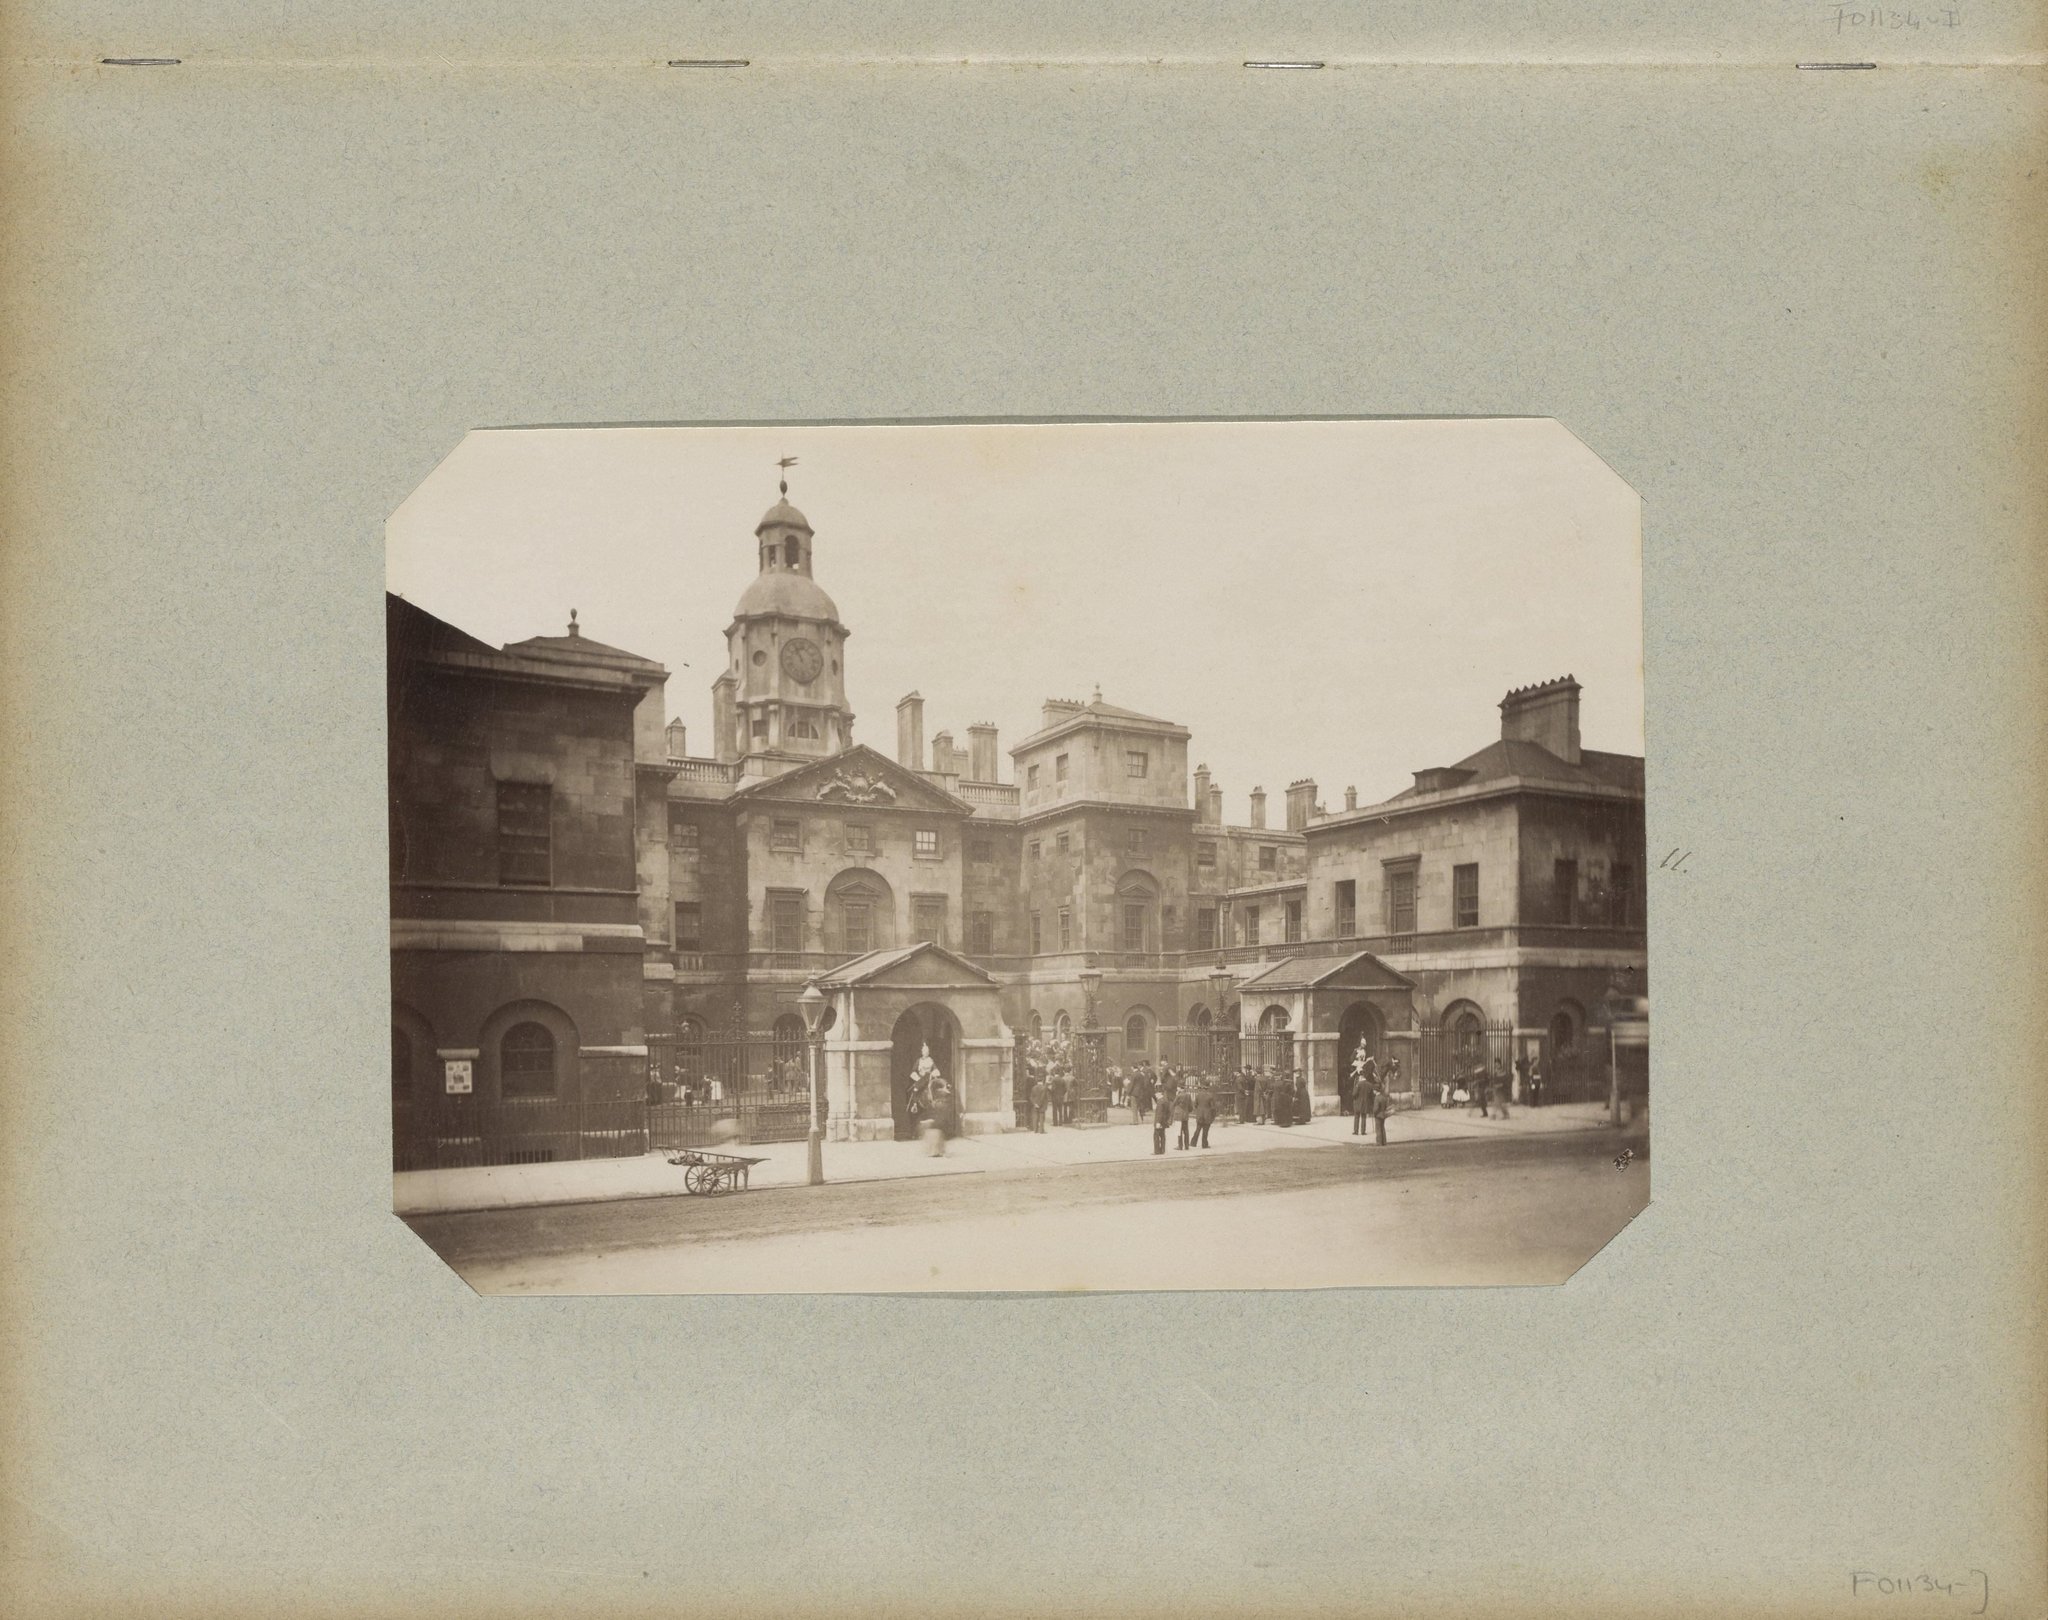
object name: photograph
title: Whitehall in Londen met Horseguards en voorbijgangers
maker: Anonymous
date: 1880-1910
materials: paper, photographic support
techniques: albumen print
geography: london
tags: riding a horse, ass, or mule; rider, horseman, exterior ~ representation of a building, london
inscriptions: number: ‘7869’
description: Onderdeel van Reisalbum met bezienswaardigheden in Engeland, Zwitserland, Frankrijk en Duitsland.